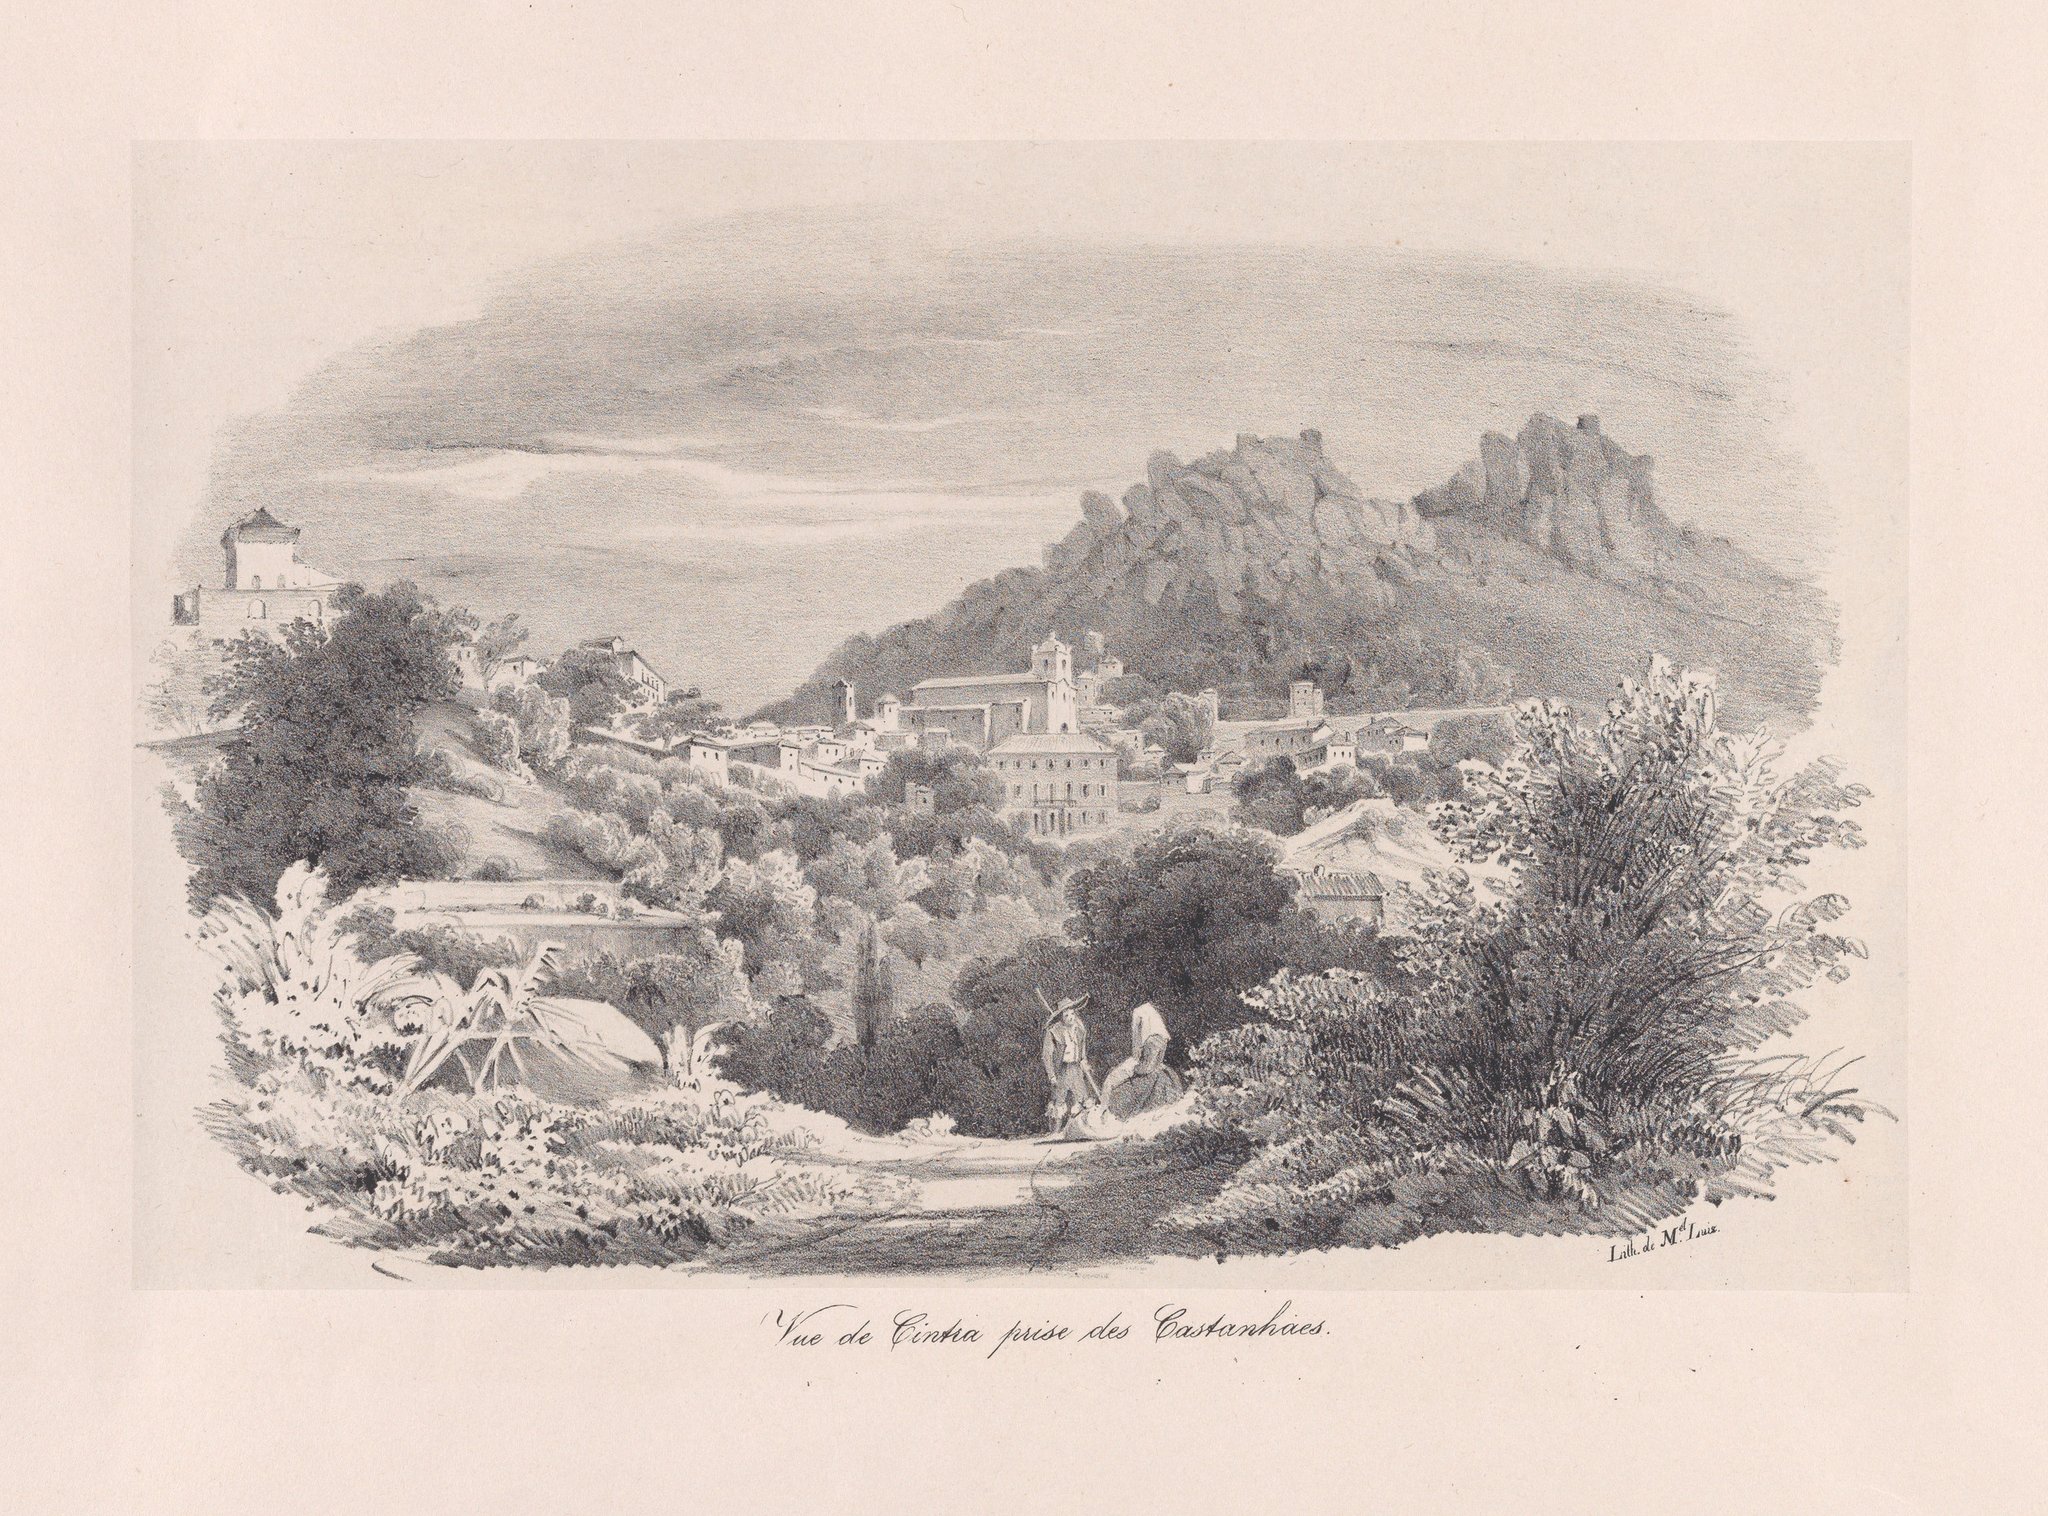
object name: print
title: View of Sintra with the Castanheiros hills in the background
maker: clementine de brelaz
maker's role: artist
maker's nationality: portuguese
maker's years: 1811-1892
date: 1840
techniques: lithograph